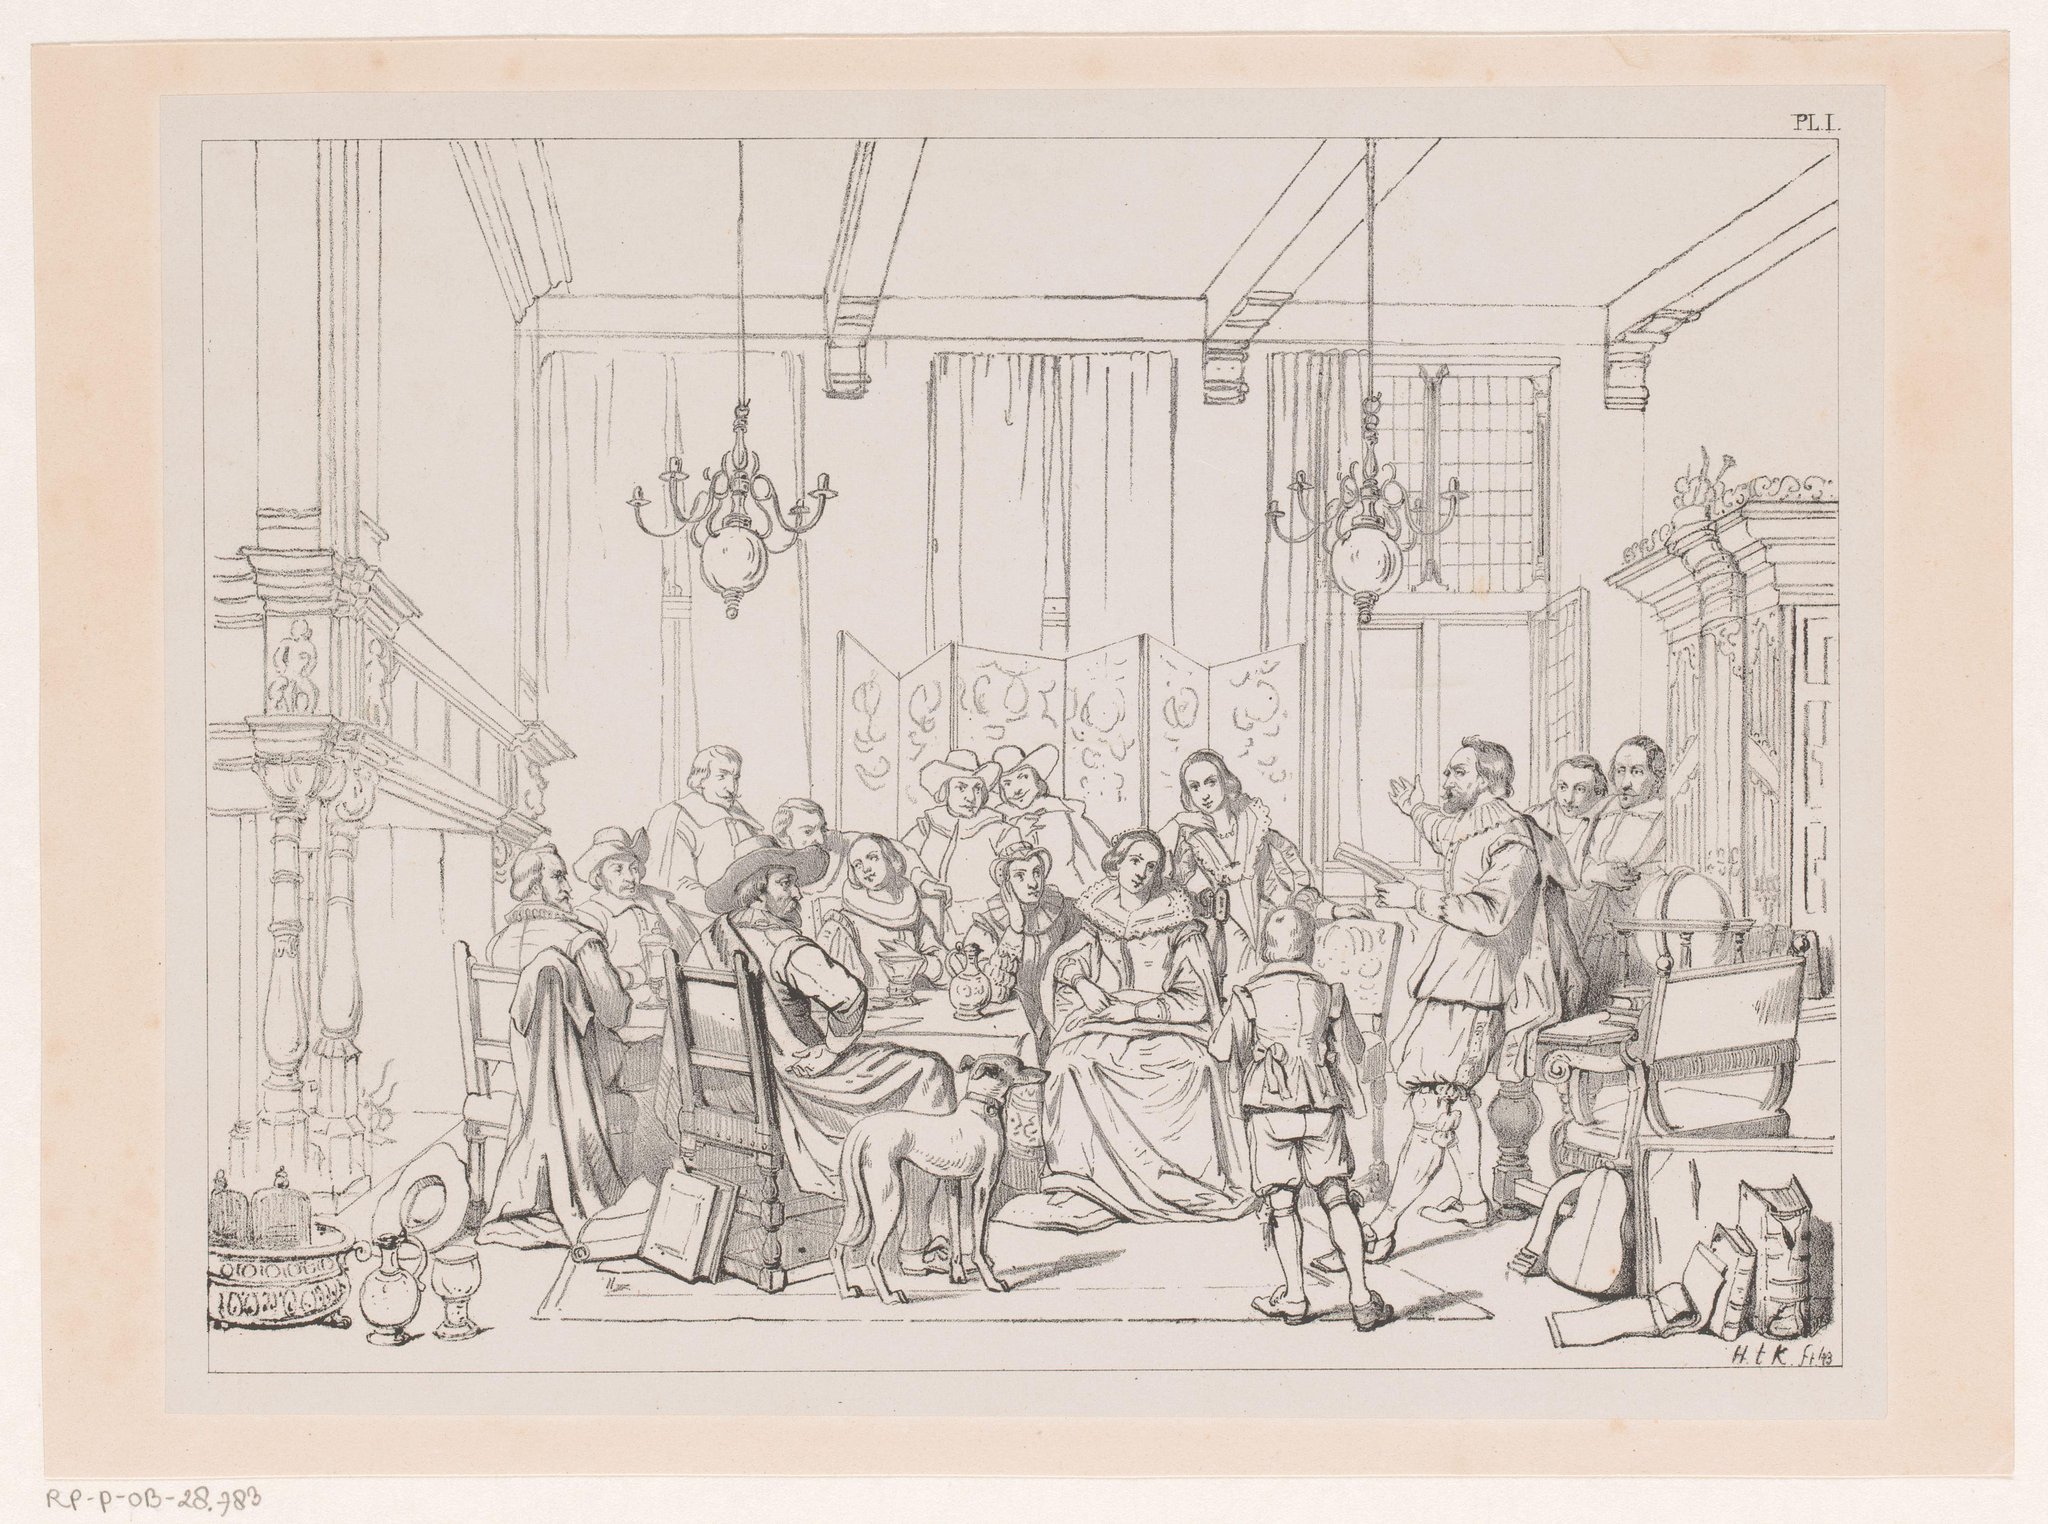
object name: print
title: Gezelschap luisterend naar een voordracht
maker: herman frederik carel ten kate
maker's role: draughtsman, painter, print maker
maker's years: 1822-1891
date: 1843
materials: paper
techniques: lithograph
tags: arm stretched sidewards (+ expressive connotations), screen, folding screen, person addressing a group, orator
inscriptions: collector's mark: Lugt 2228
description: Rechts geeft een figuur een voordracht, zijn rechterarm gestrekt. De toehoorders zitten aan een tafel. Achter hen staat een kamerscherm. Genummerd rechtsboven: Pl. I.